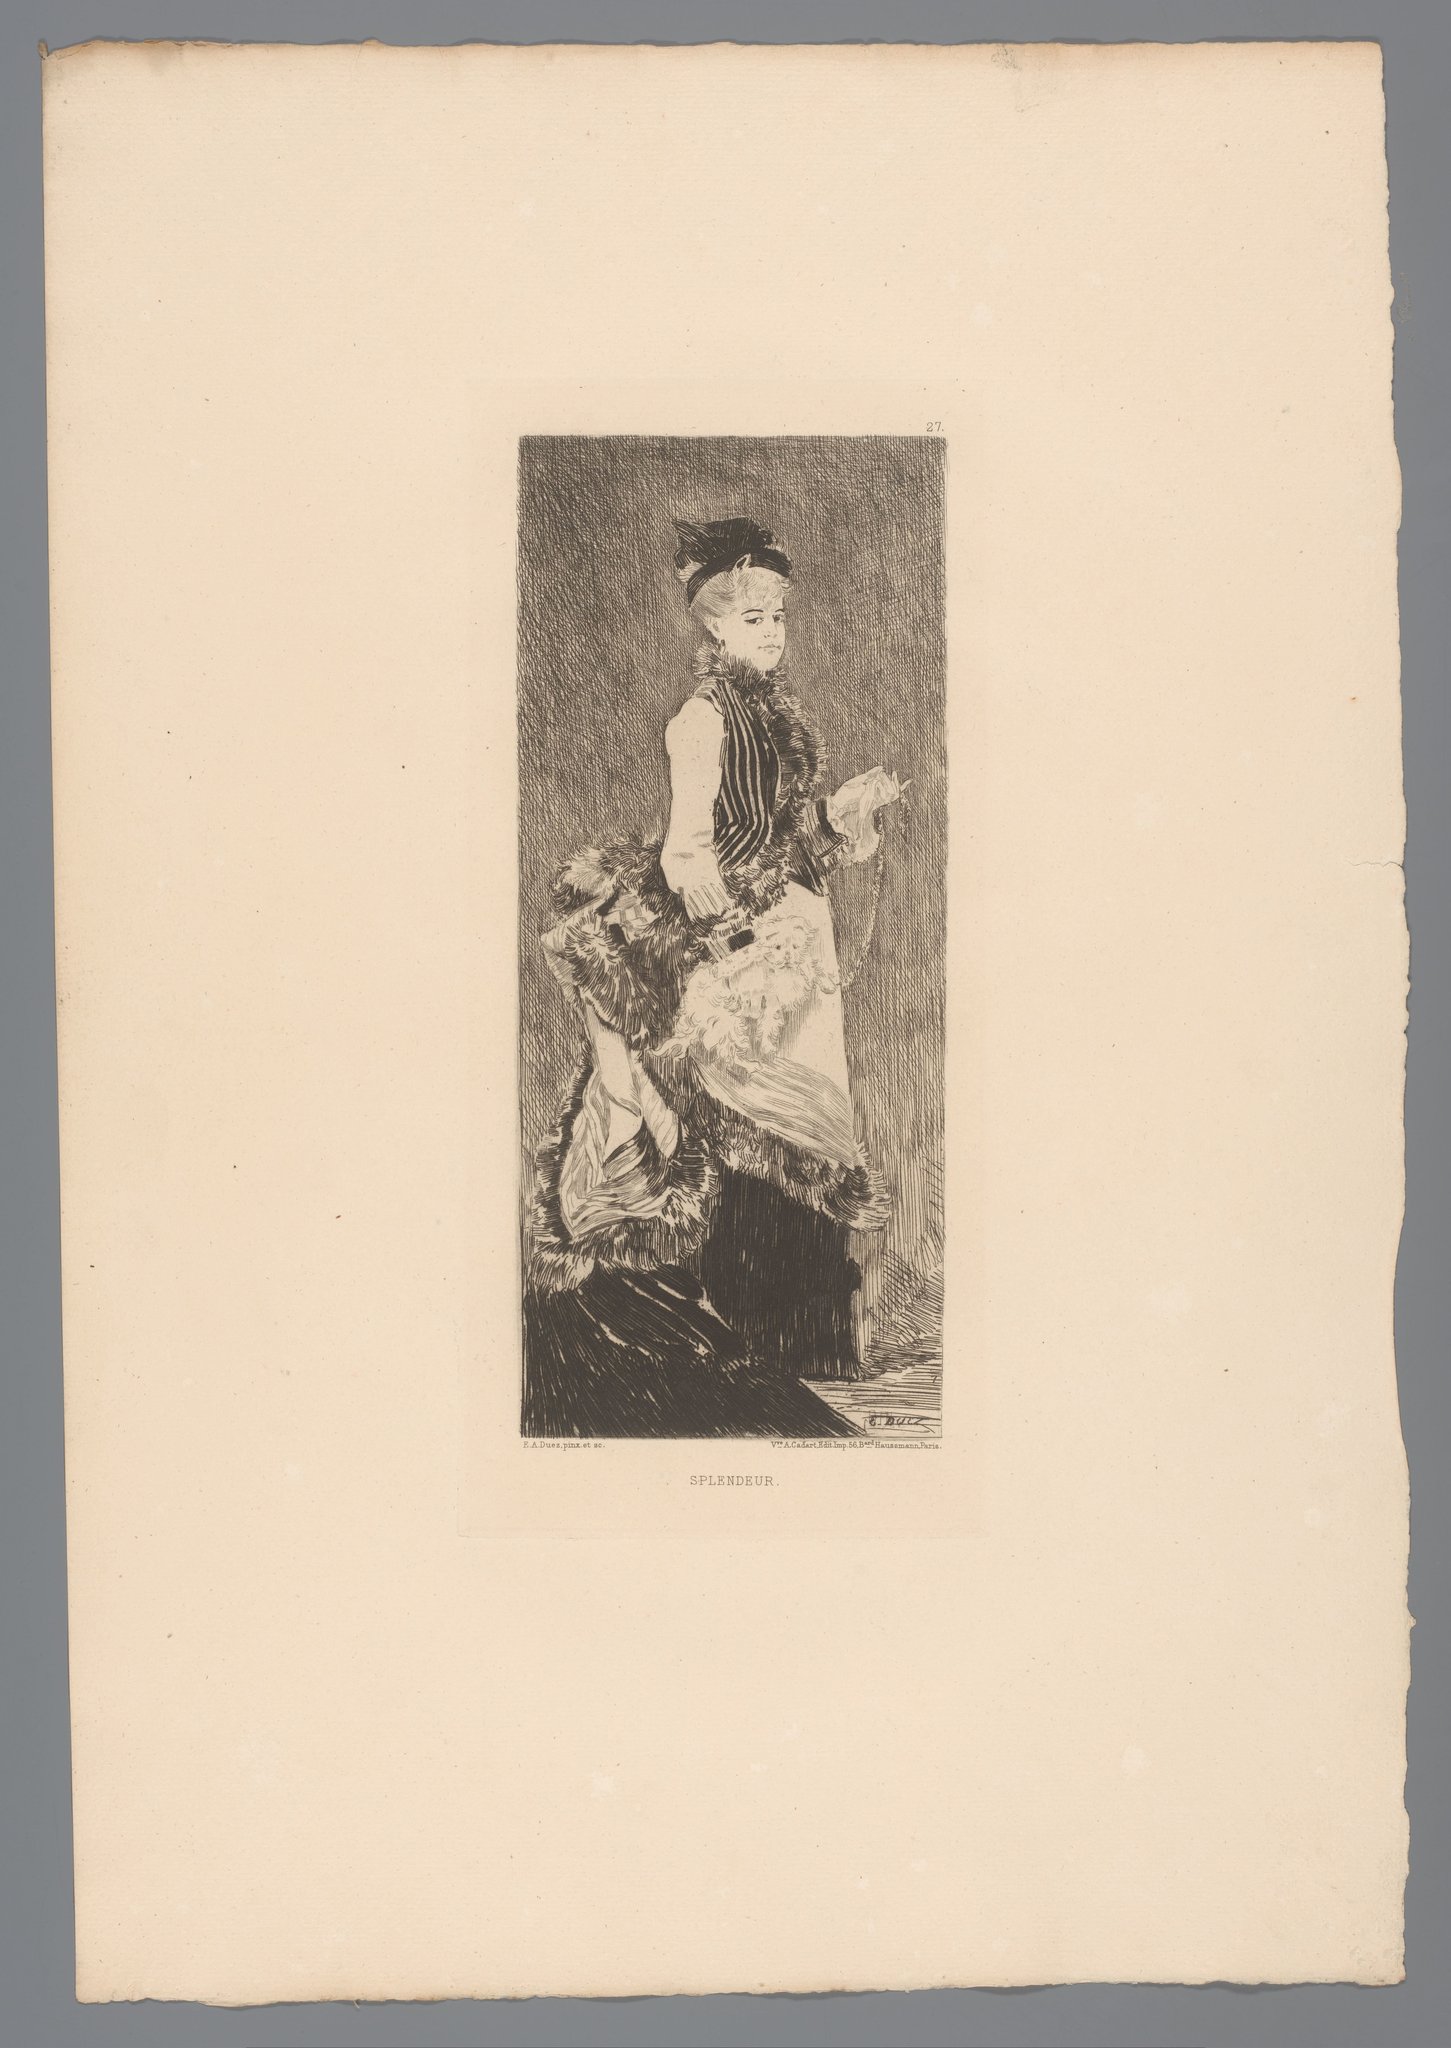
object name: print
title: Dame met kleine hond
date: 1878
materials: paper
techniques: drypoint, etching, intaglio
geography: paris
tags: adult woman, standing figure - aa - female human figure, dog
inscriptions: collector's mark: Lugt 2760, collector's mark: Lugt 2228, collector's mark: ‘AFE v S’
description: Staande vrouw in modieuze japon afgewerkt met bont, met in haar hand een wit hondje.